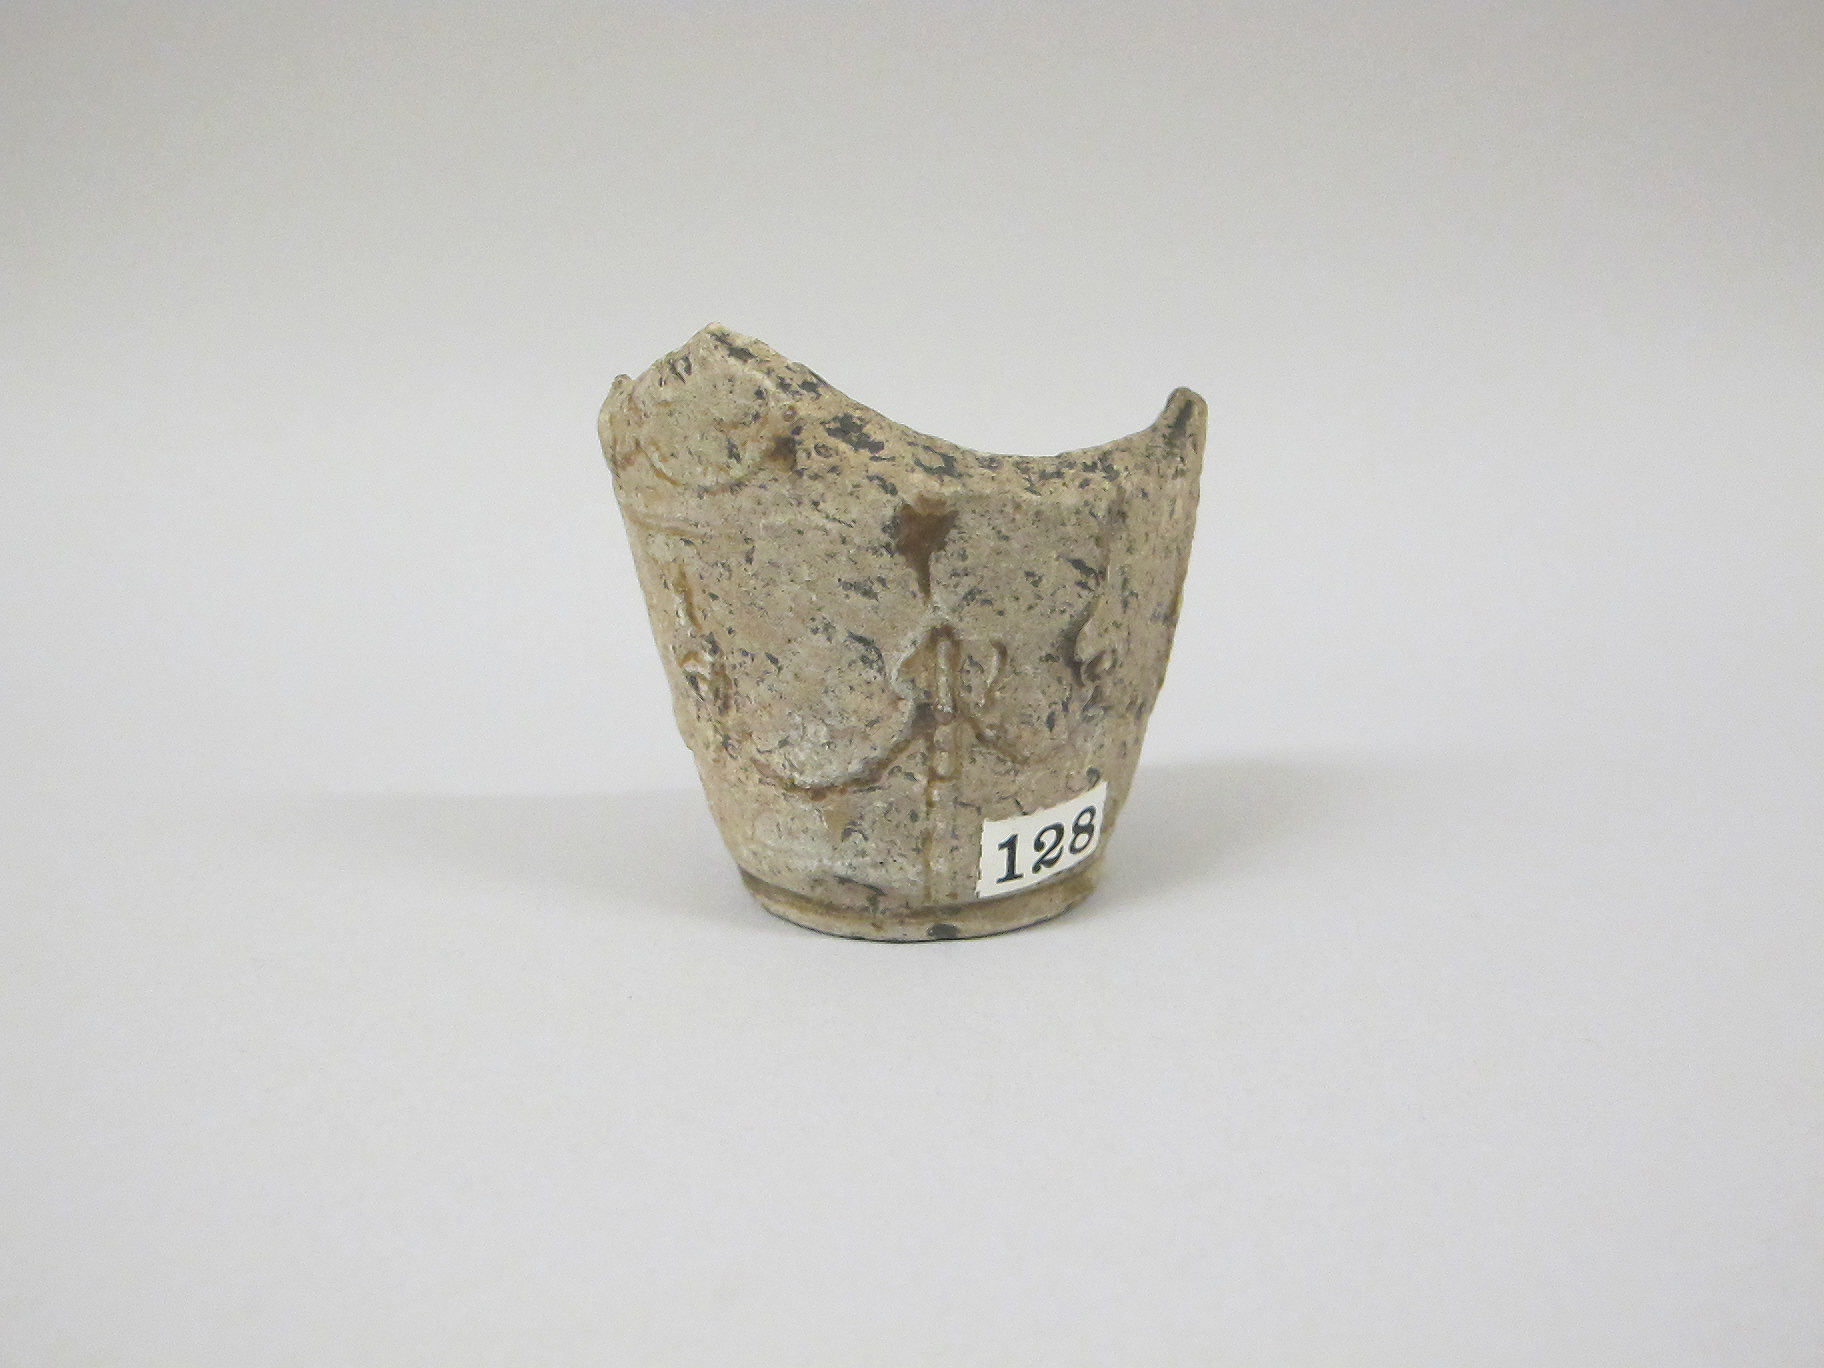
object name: vase fragment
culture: roman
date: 670 BCE-330 CE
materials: terracotta